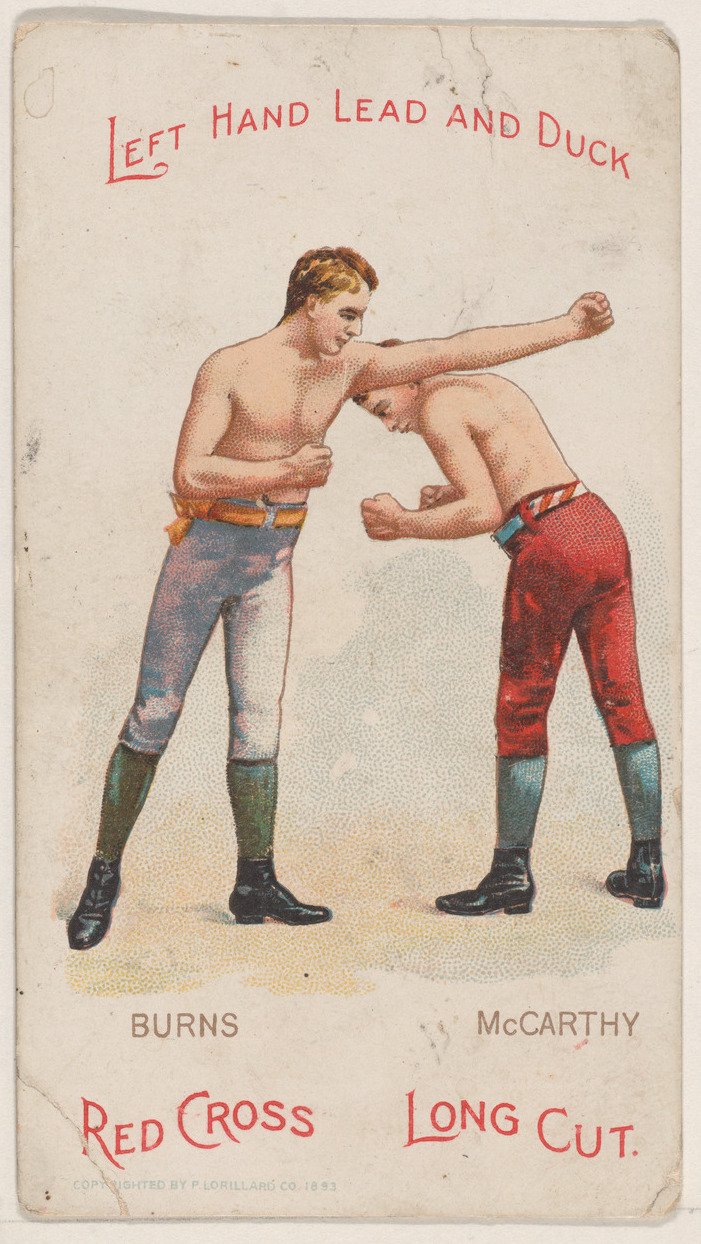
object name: print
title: Left Hand Lead and Duck, Bobby Burns and Cal McCarthy, from the Boxing Positions and Boxers series (N266) issued by P. Lorillard Company to promote Red Cross Long Cut Tobacco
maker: p. lorillard company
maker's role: publisher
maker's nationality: american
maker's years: 1760-2014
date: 1893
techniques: color lithograph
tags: men,boxing,athletes